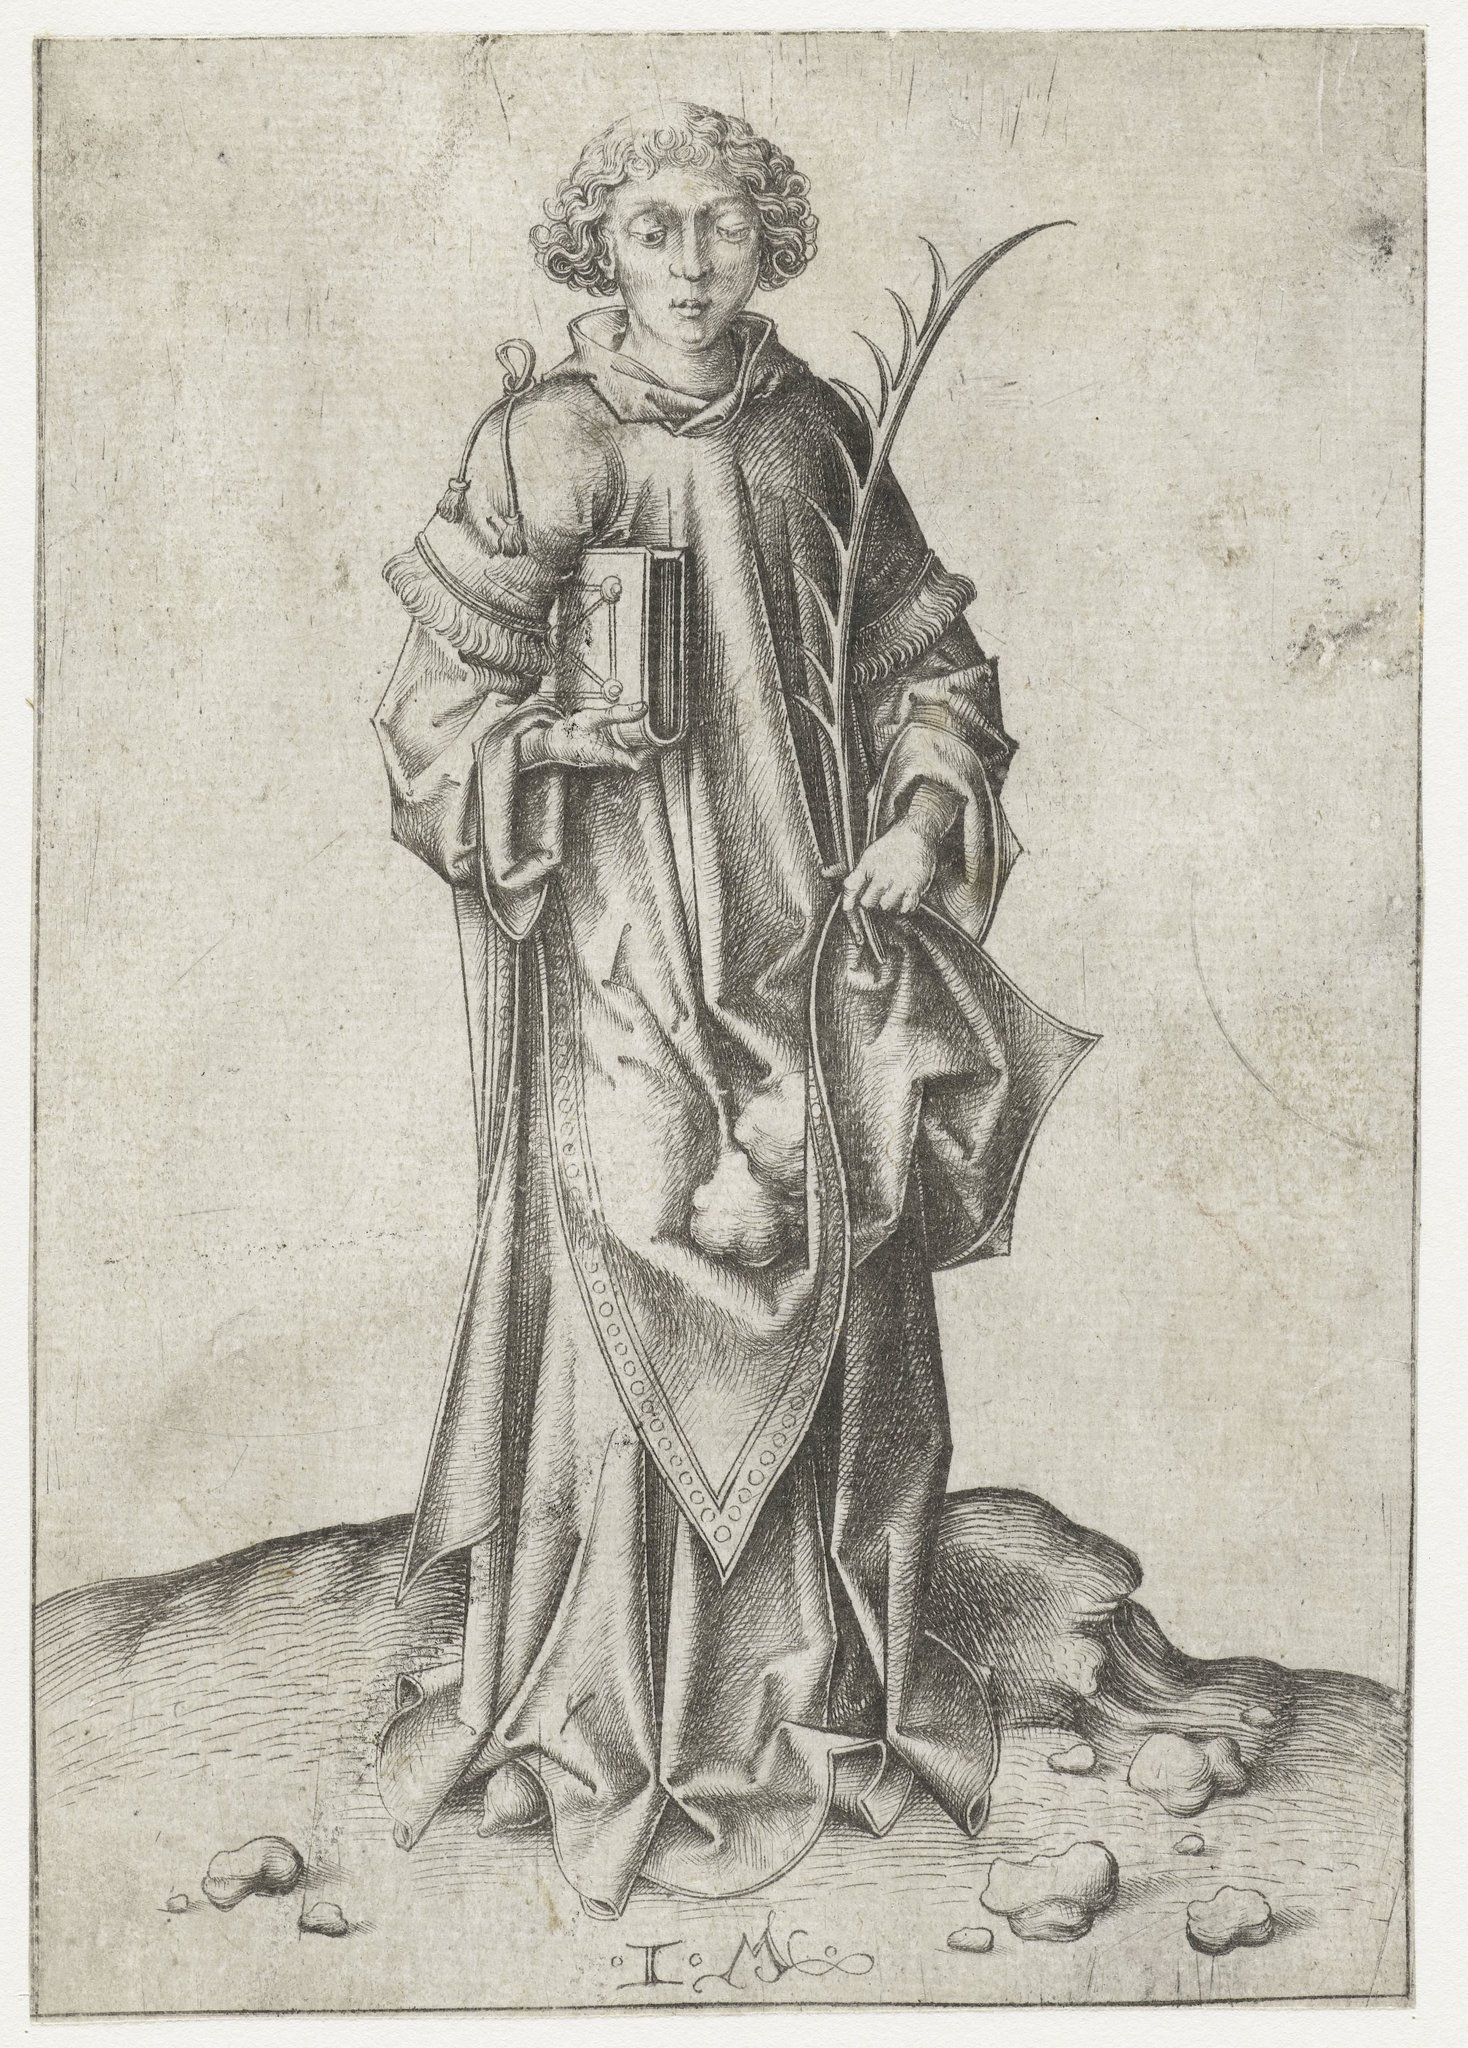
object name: print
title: Heilige Stefanus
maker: israhel van meckenem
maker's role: print maker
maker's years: 1440-1517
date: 1455-1503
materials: paper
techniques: engraving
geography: bocholt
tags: the deacon and (proto)martyr stephen; possible attributes: censer, stones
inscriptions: collector's mark: Lugt 240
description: De Heilige Stefanus, een palmtak in de ene hand en een boek in de andere, draagt enkele stenen in een plooi van zijn gewaad.